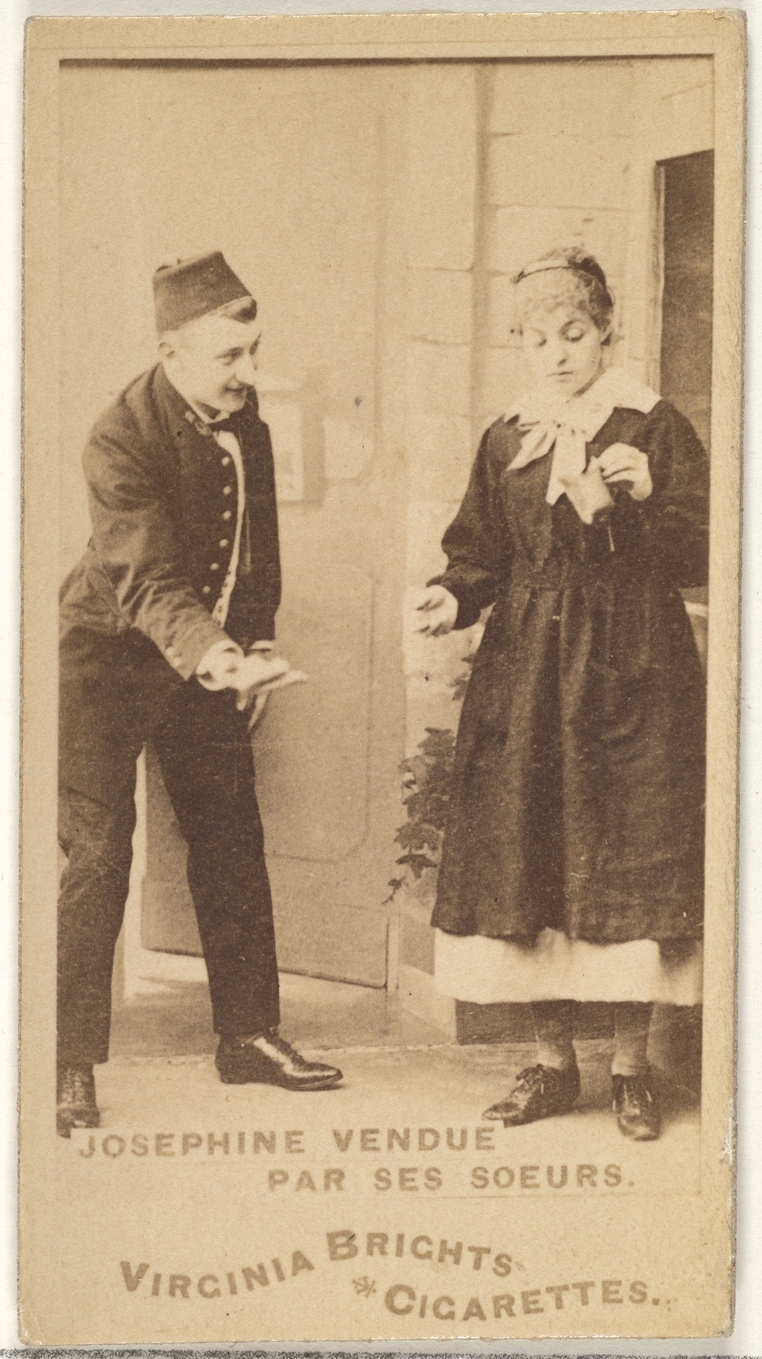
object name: photograph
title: Josephine Vendue, Par Ses Soeurs, from the Actors and Actresses series (N45, Type 1) for Virginia Brights Cigarettes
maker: allen & ginter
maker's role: publisher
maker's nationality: american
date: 1888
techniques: albumen silver print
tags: men,women,actors,actresses